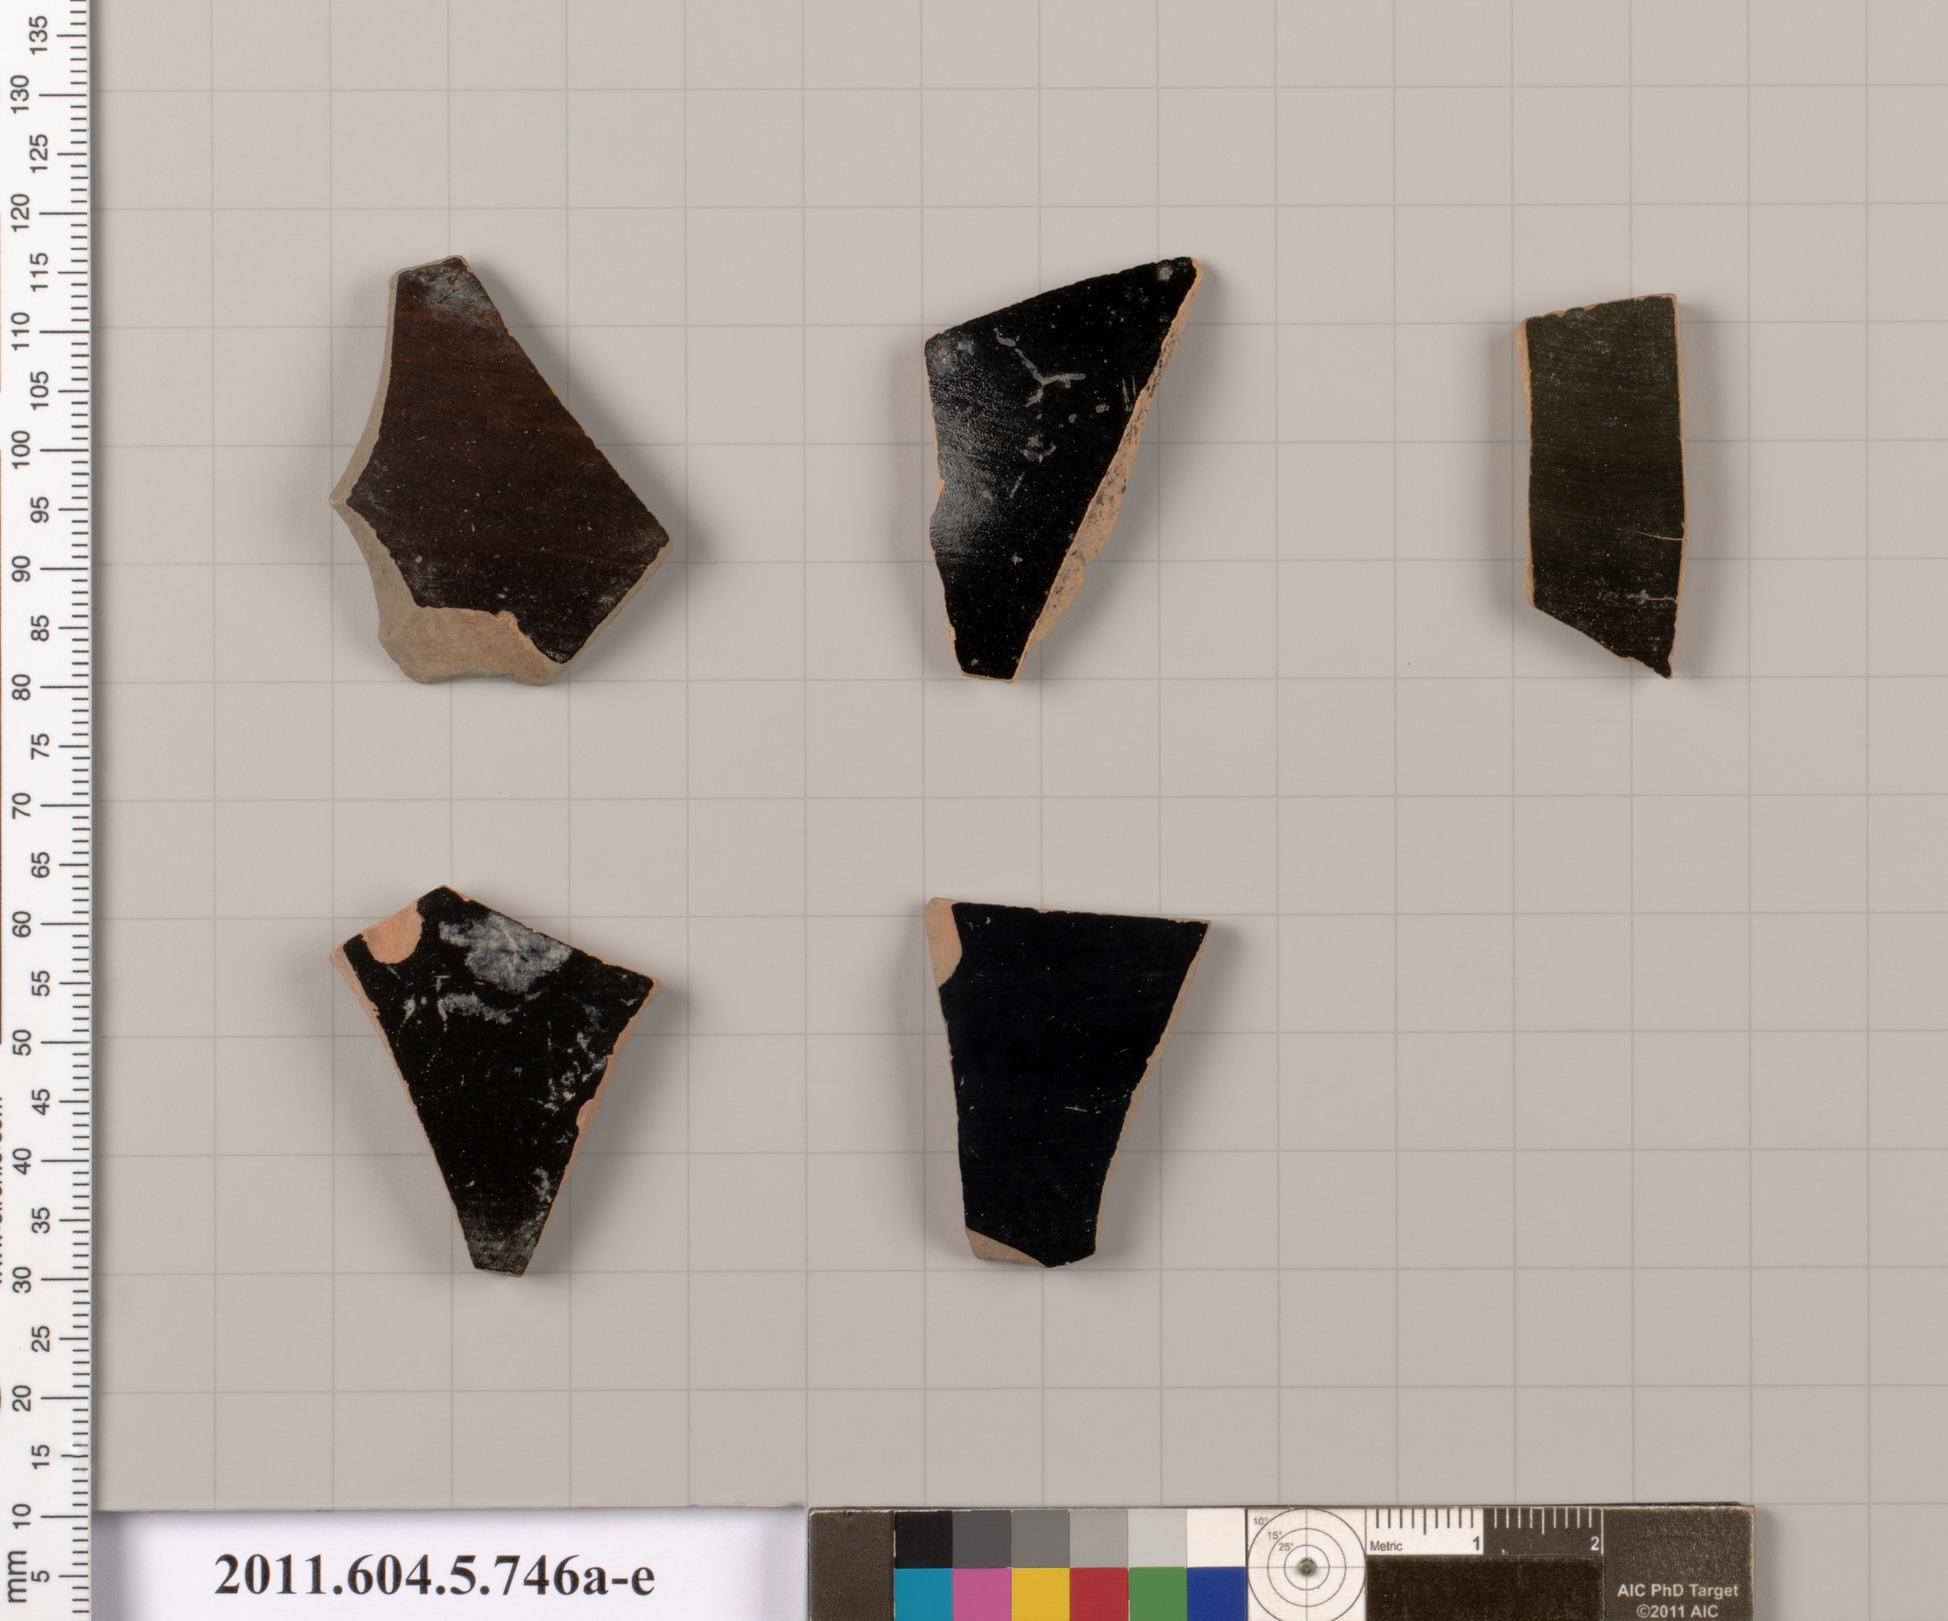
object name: kylix fragment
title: Terracotta fragments of kylikes (drinking cups)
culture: greek, attic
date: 600-401 BCE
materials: terracotta